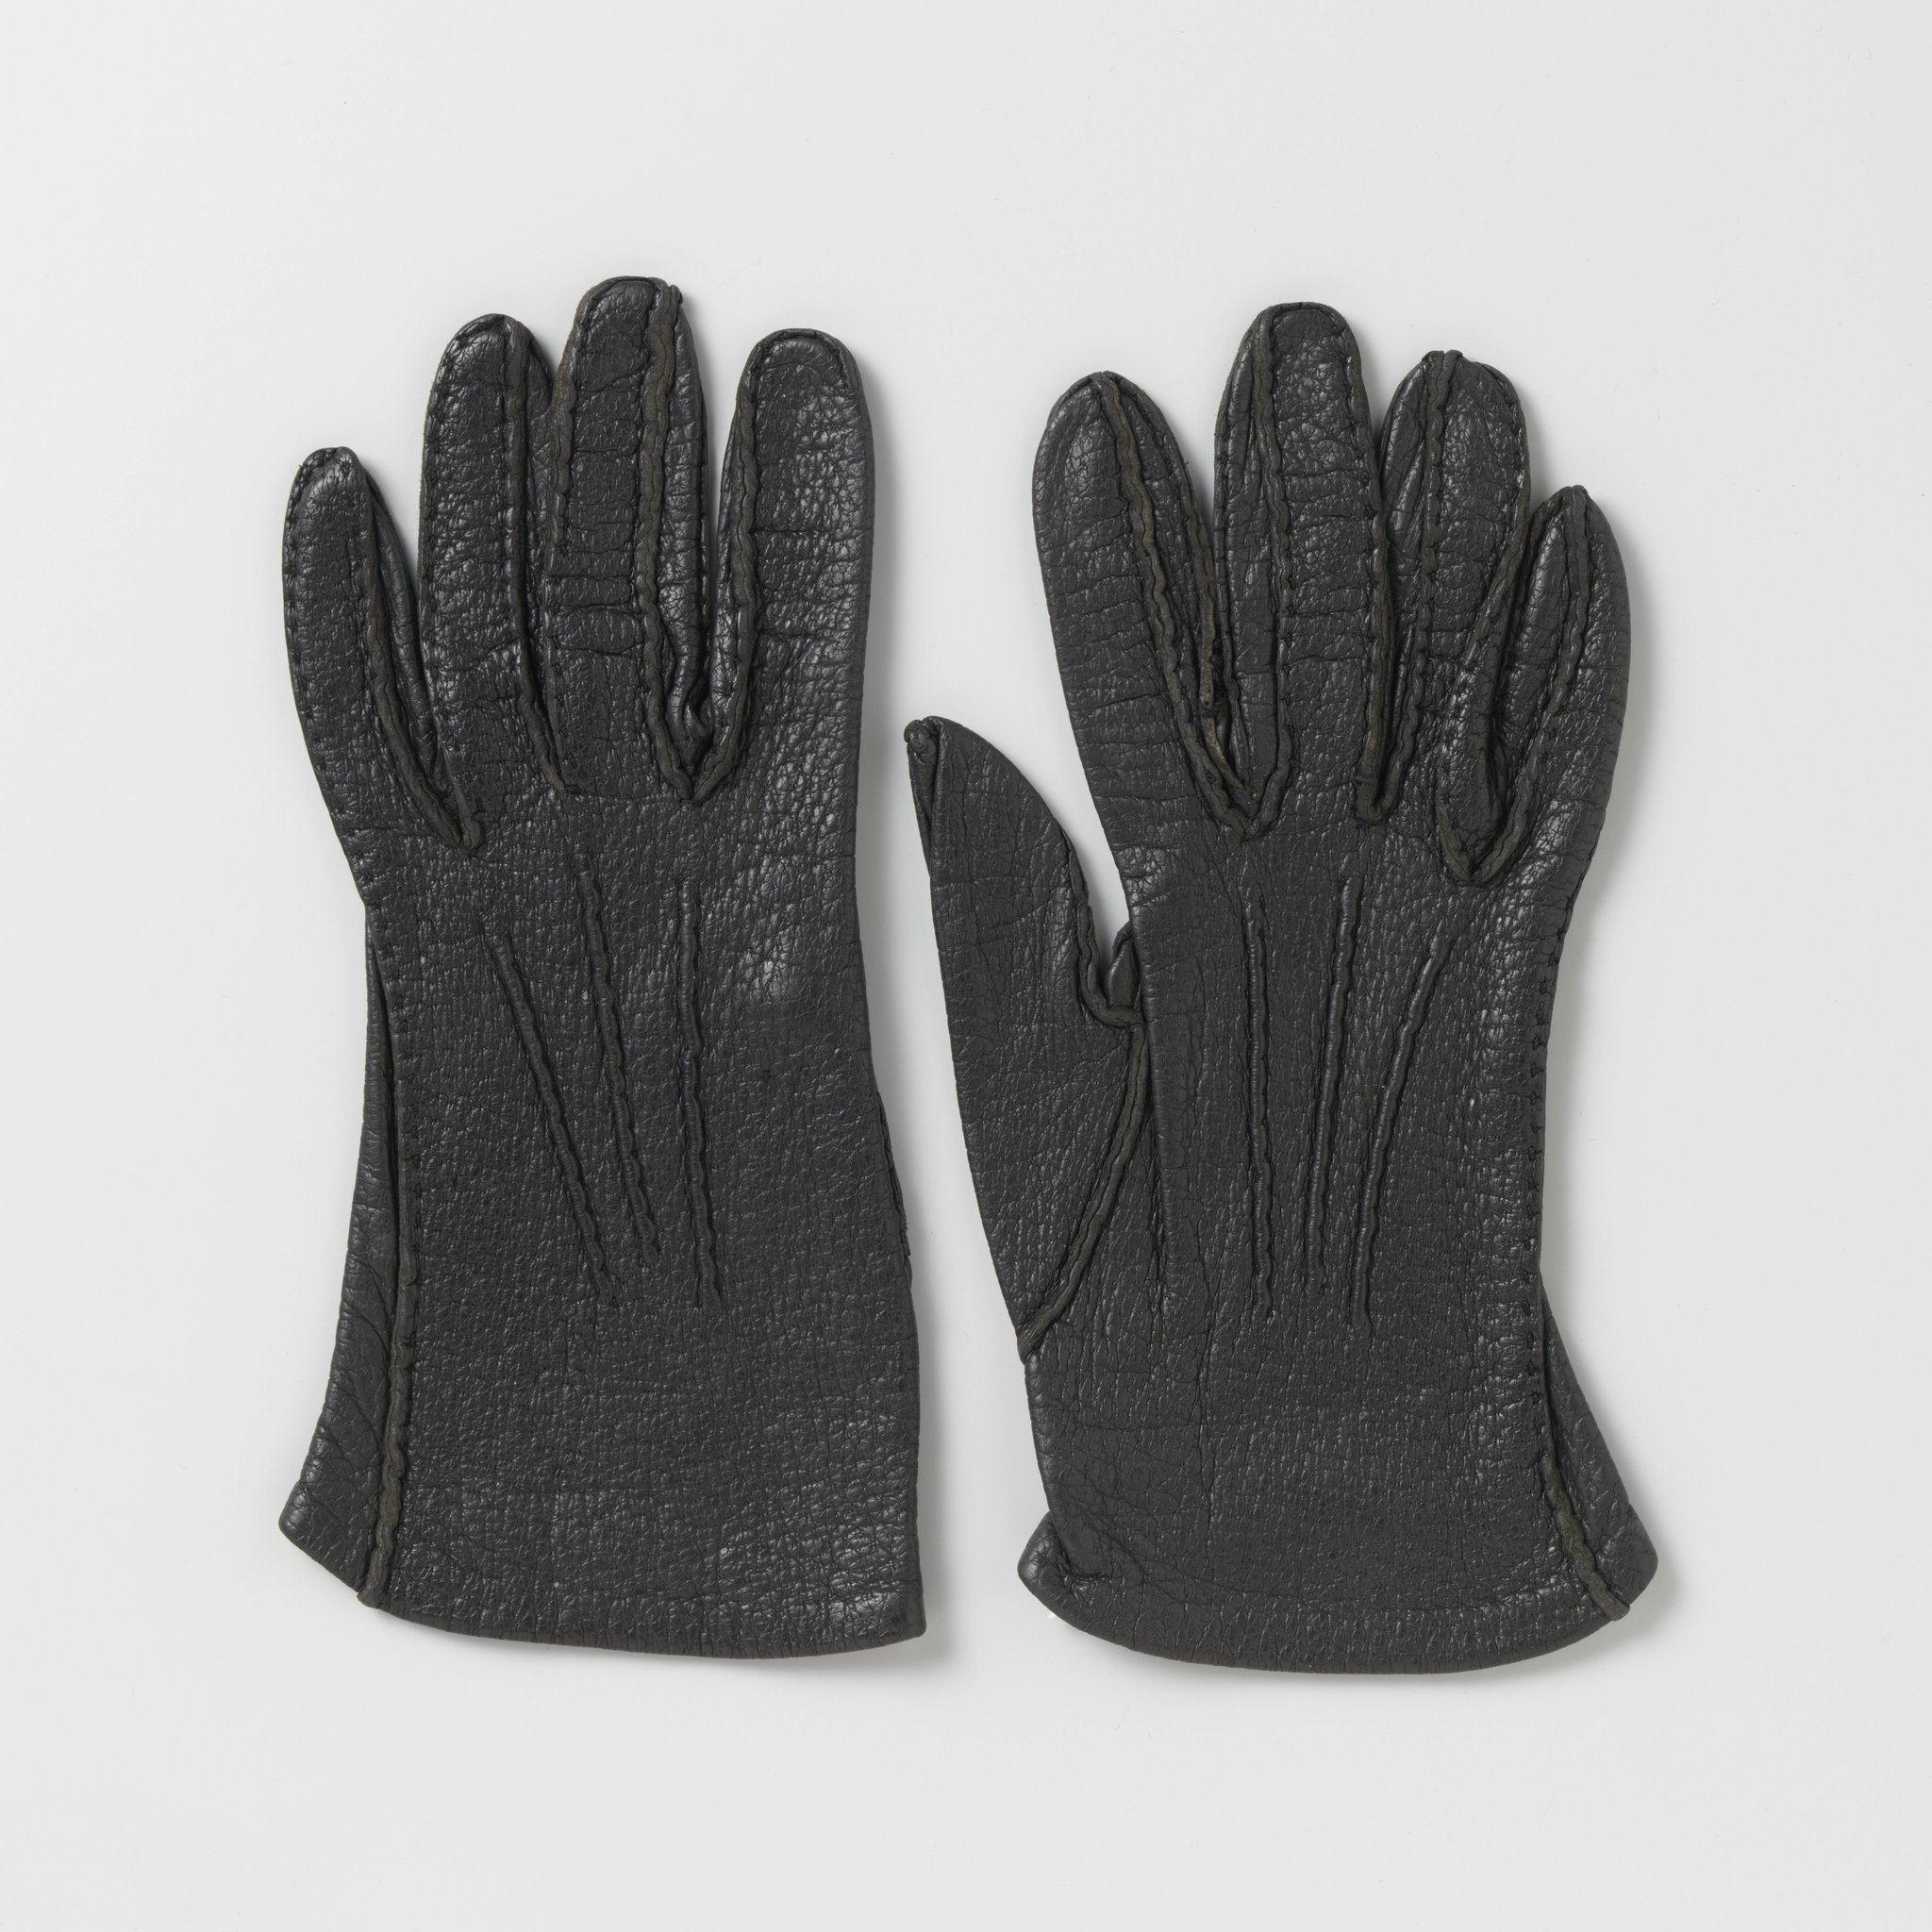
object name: clothing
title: Handschoen van zwart leer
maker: Anonymous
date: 1900-1915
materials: leather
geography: netherlands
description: Linker handschoen van zwart leer met op de rug drie uitstralende koorden, vermoedelijk varkensleer.